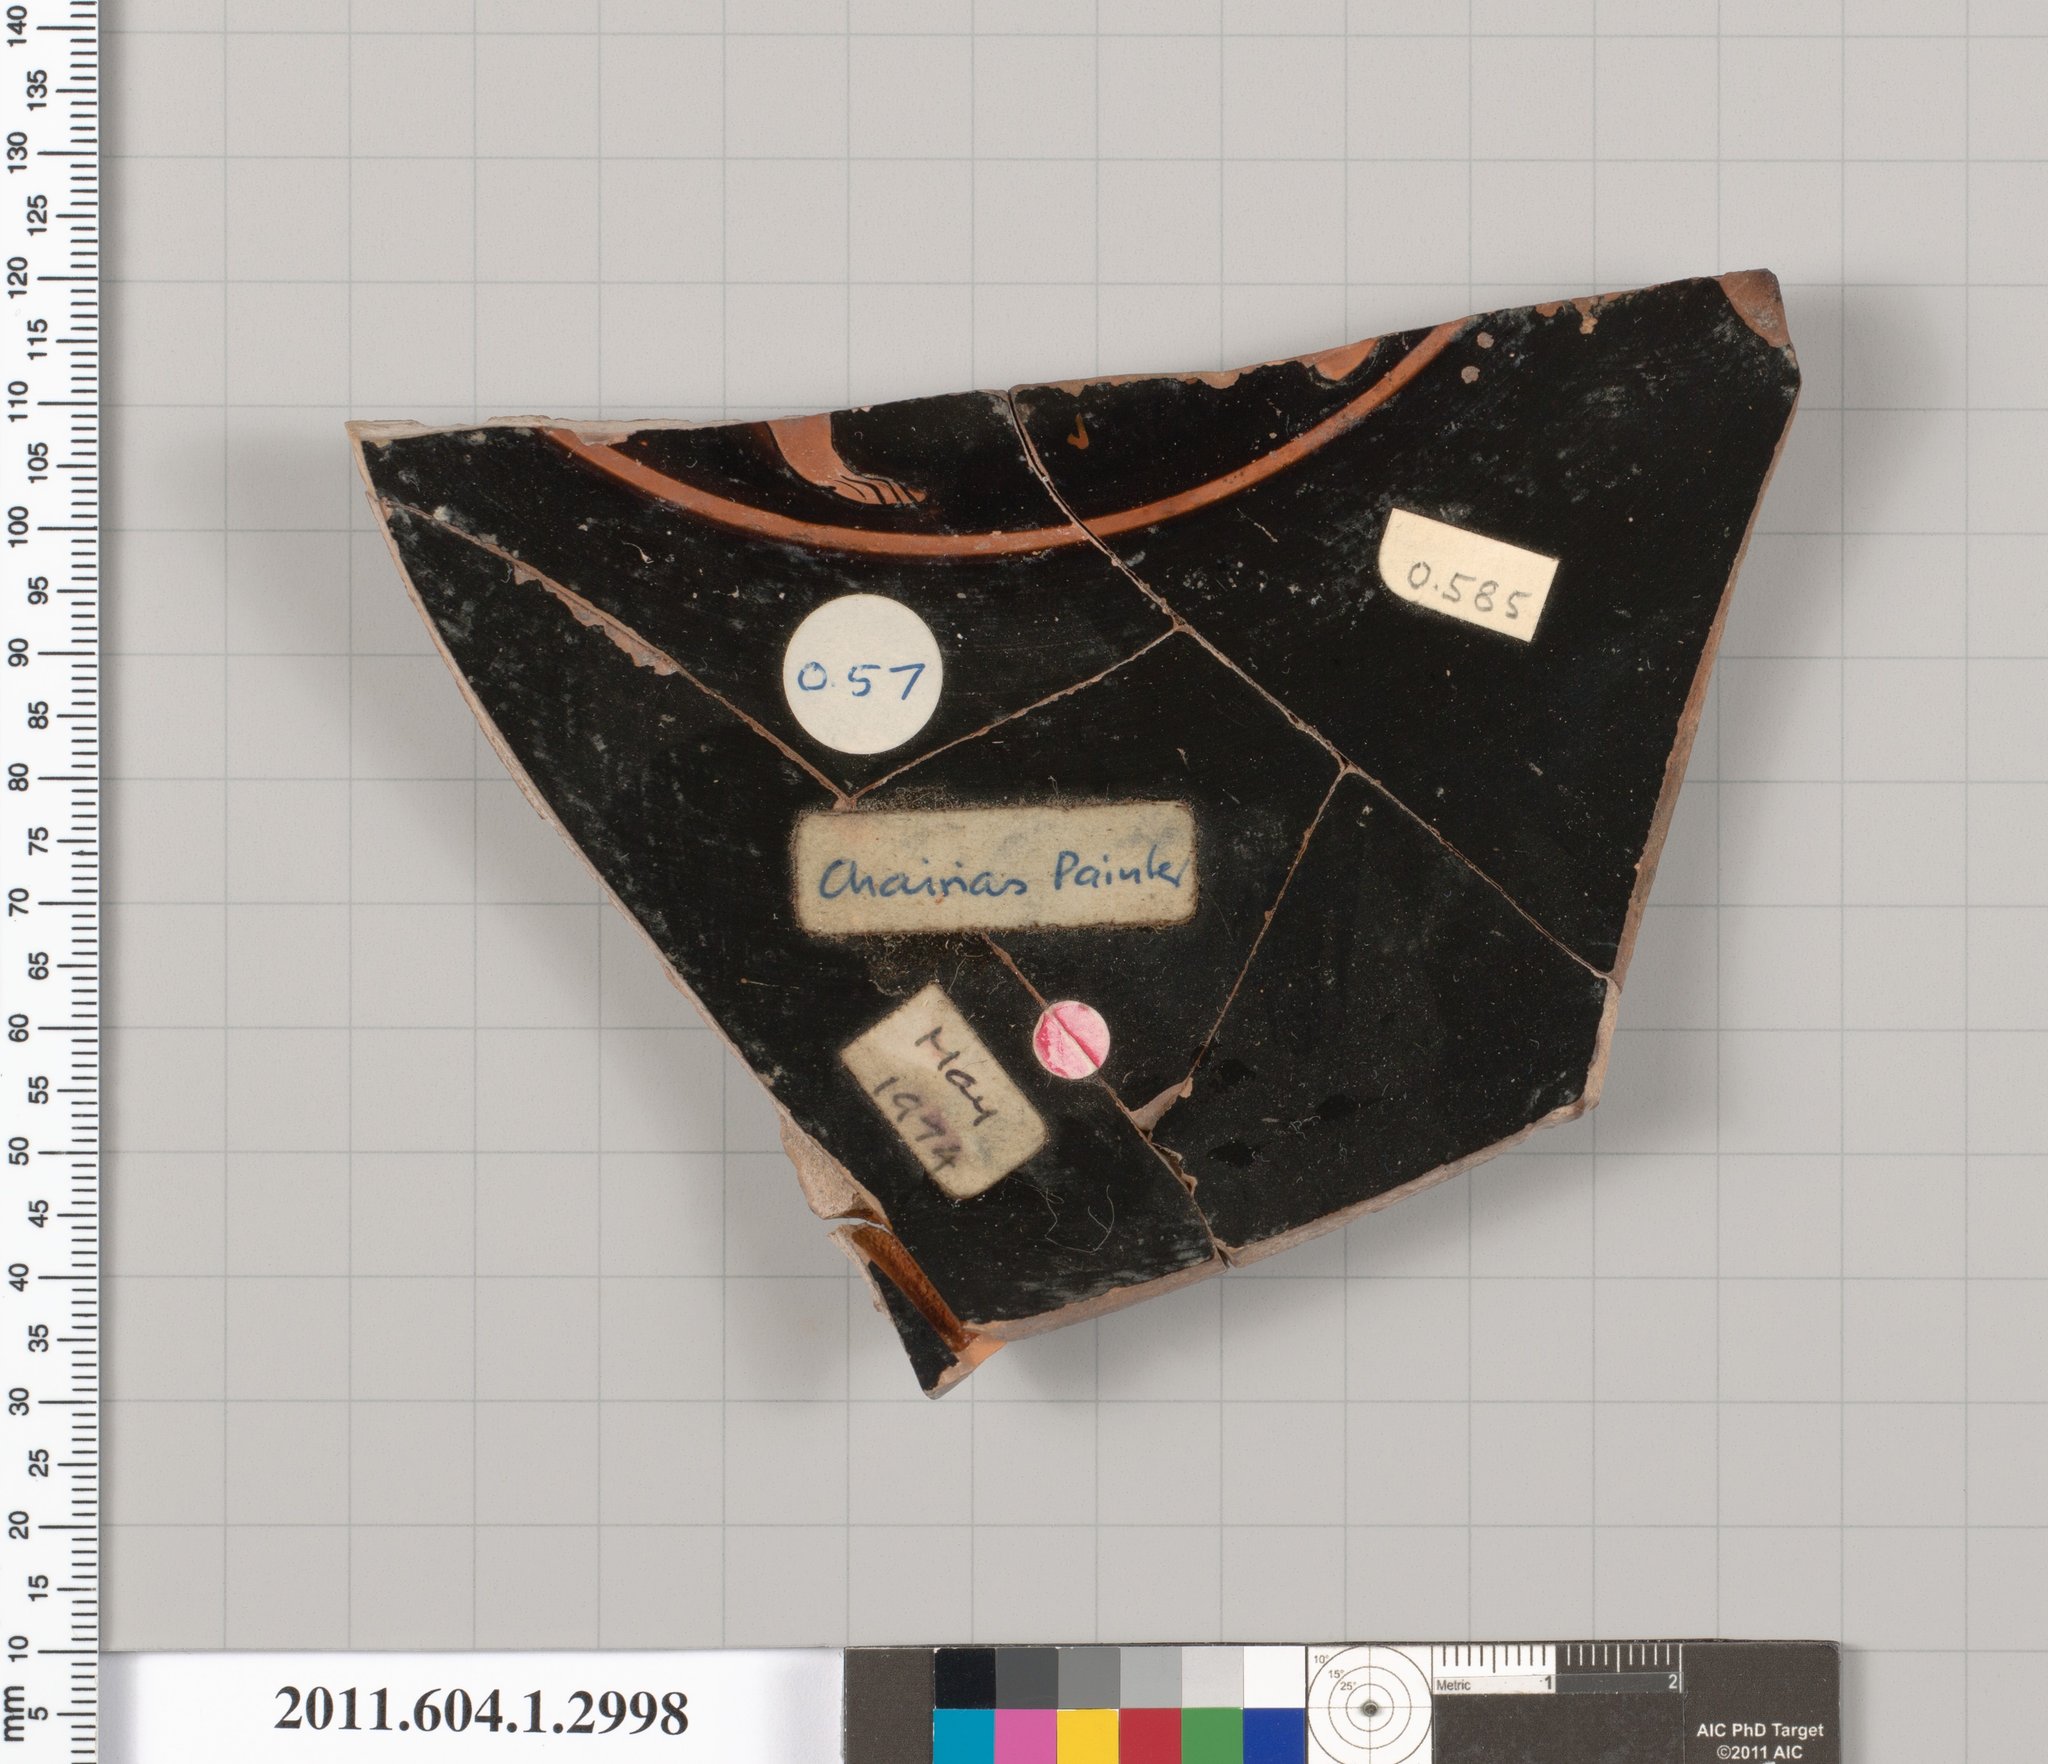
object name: kylix fragment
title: Terracotta fragment of a kylix (drinking cup)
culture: greek, attic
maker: chairias painter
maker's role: artist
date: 520-500 BCE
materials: terracotta